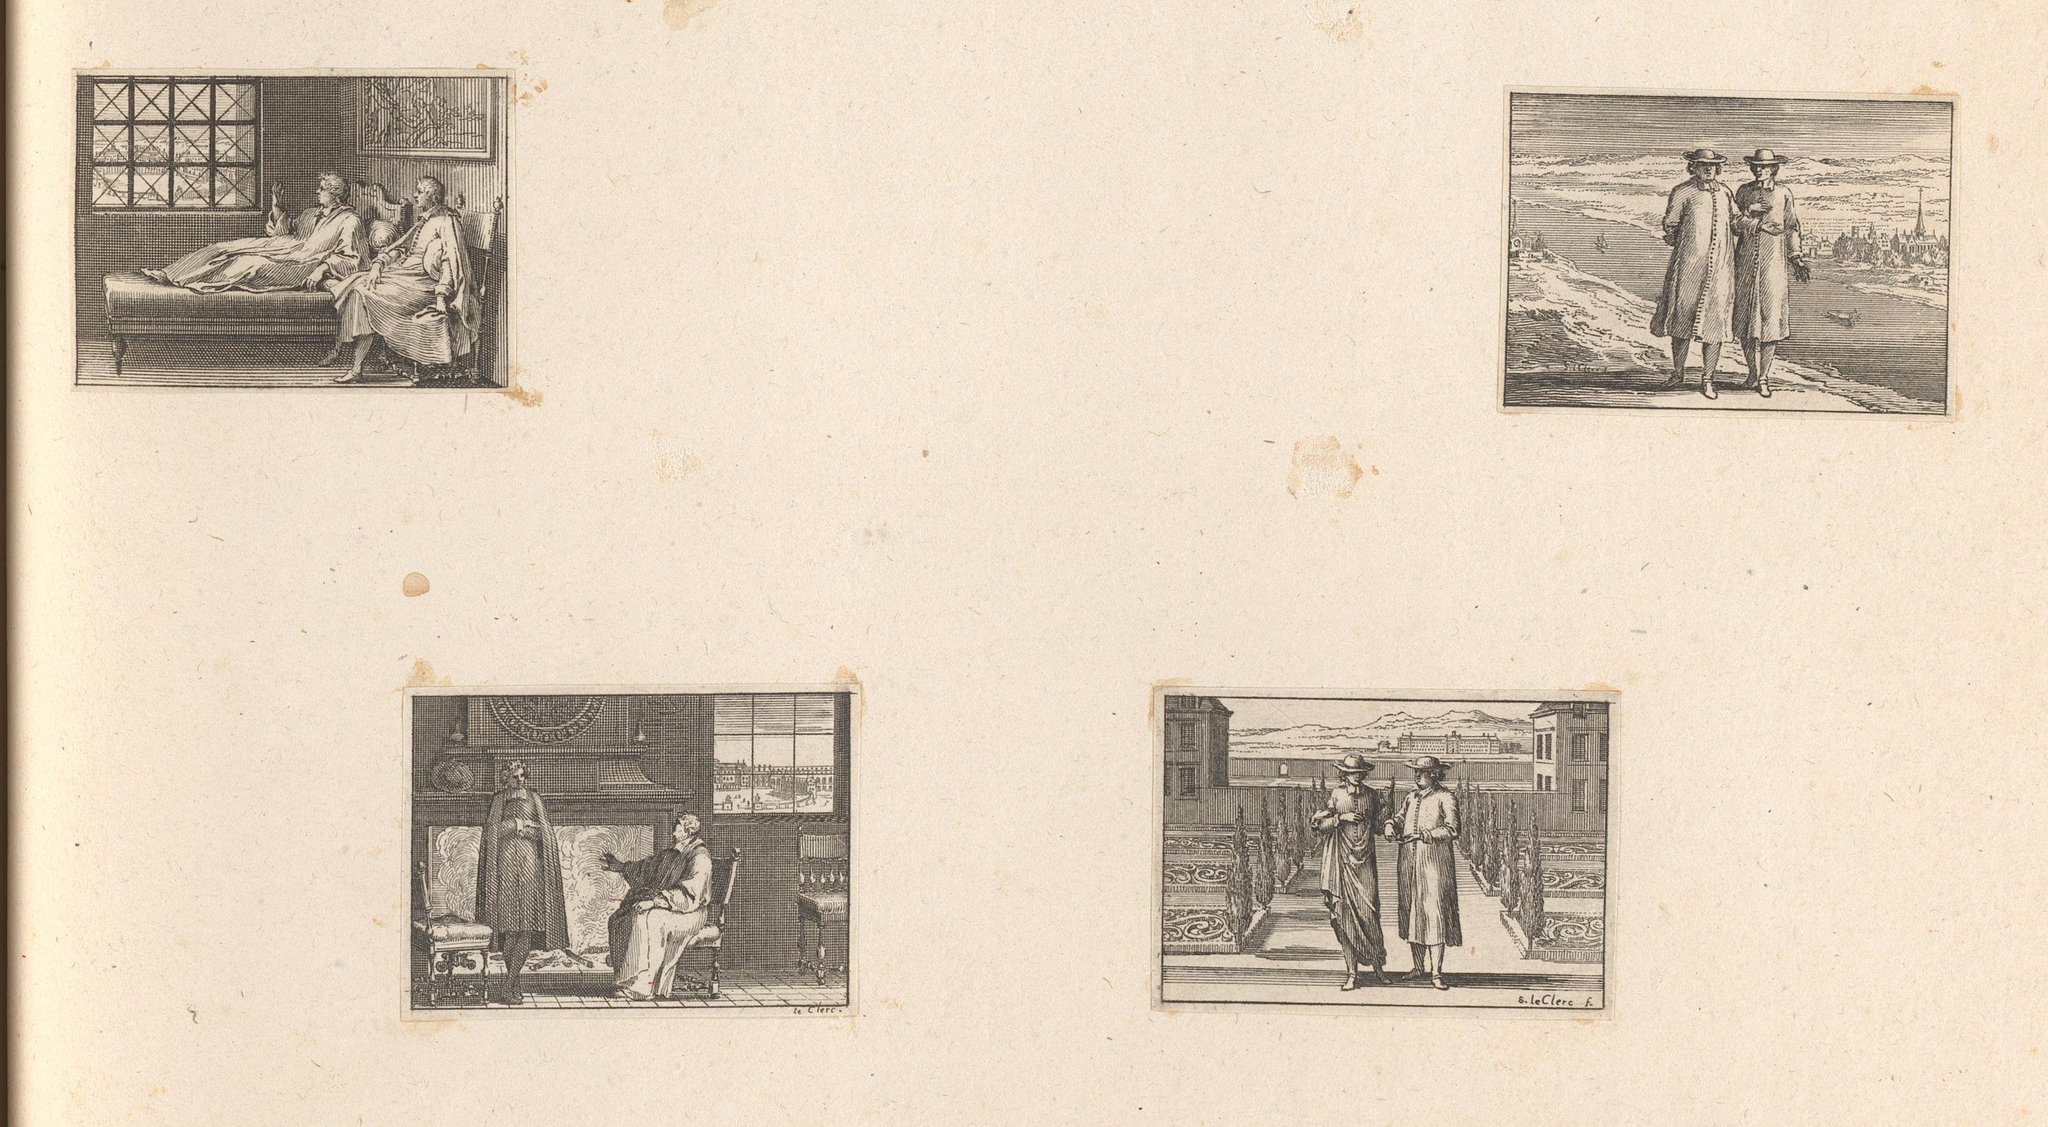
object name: album leaf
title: Vier vignetten met François-Timoléon de Choisy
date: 1684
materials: paper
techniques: etching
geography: paris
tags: paris, françois-timoléon de choisy, historical persons, vignette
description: Prenten uit: Choisy, François-Timoléon, abbé de; Dangeau, Louis de Courcillon, abbé de. Quatre dialogues (...). Parijs: Sébastien Mabre-Cramoisy, 1684.